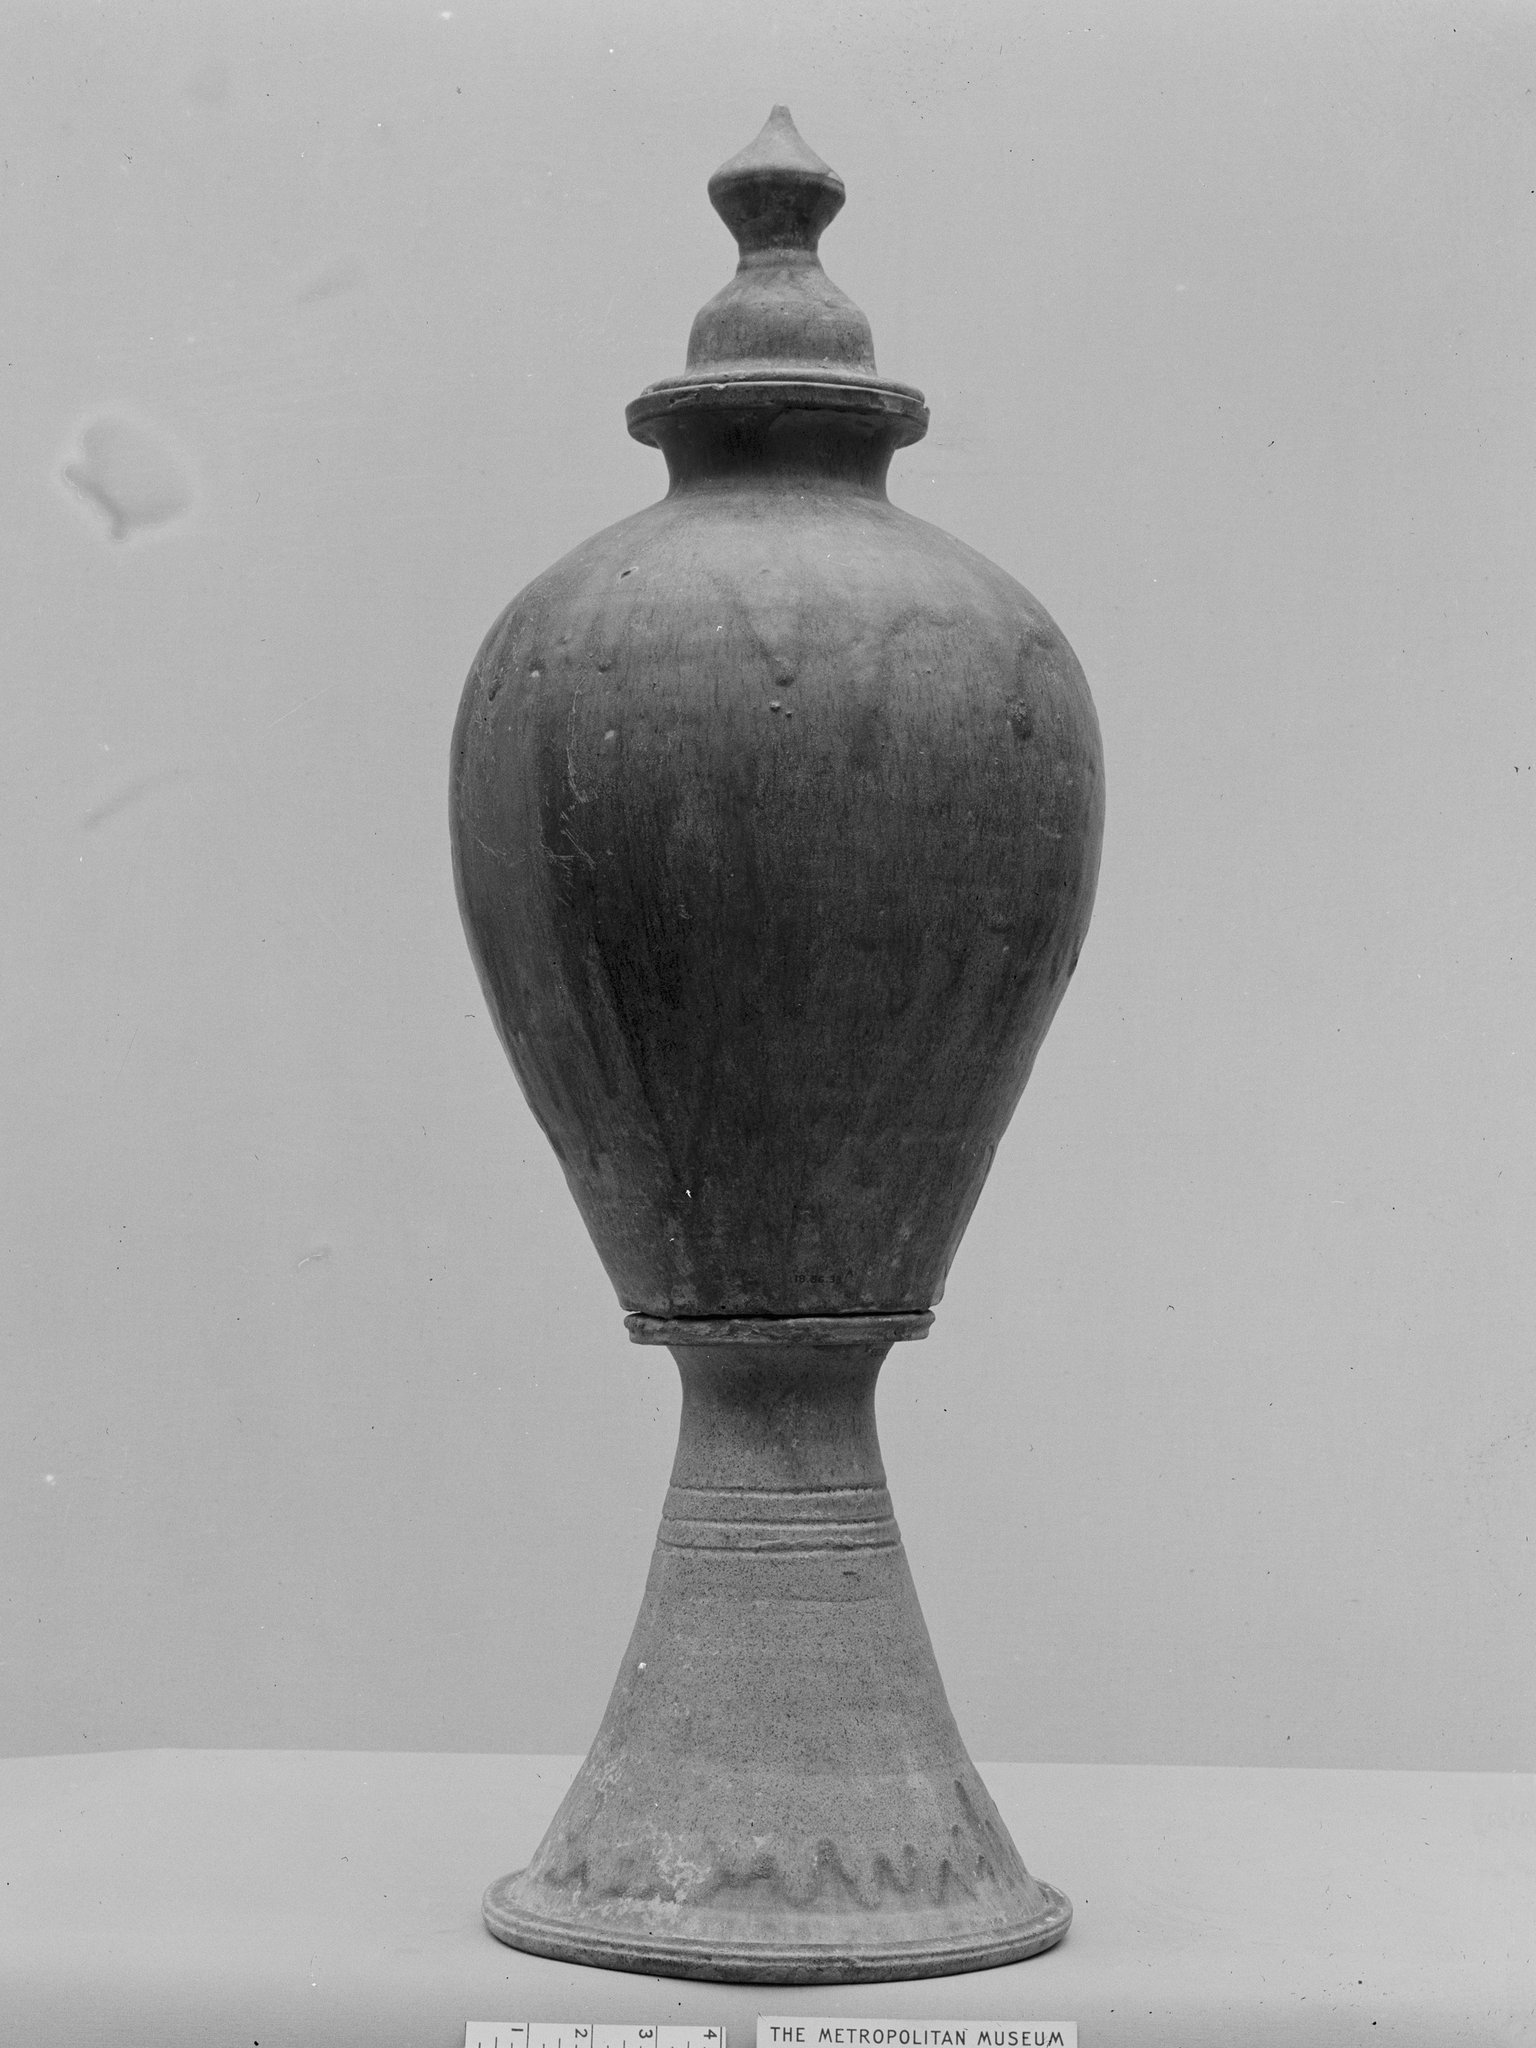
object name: jar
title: Covered jar on stand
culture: chinese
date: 618-907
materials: earthenware